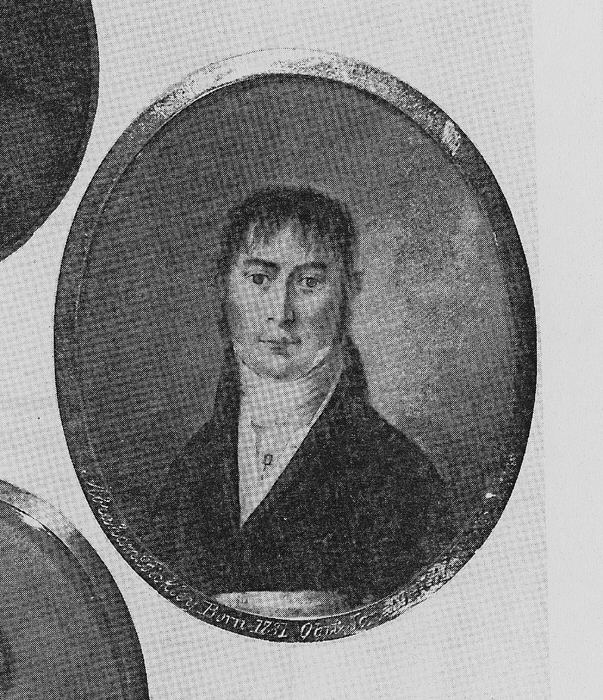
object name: painting, miniature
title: Abraham Bickley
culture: british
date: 1805-1810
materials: ivory, watercolor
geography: france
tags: men,portraits